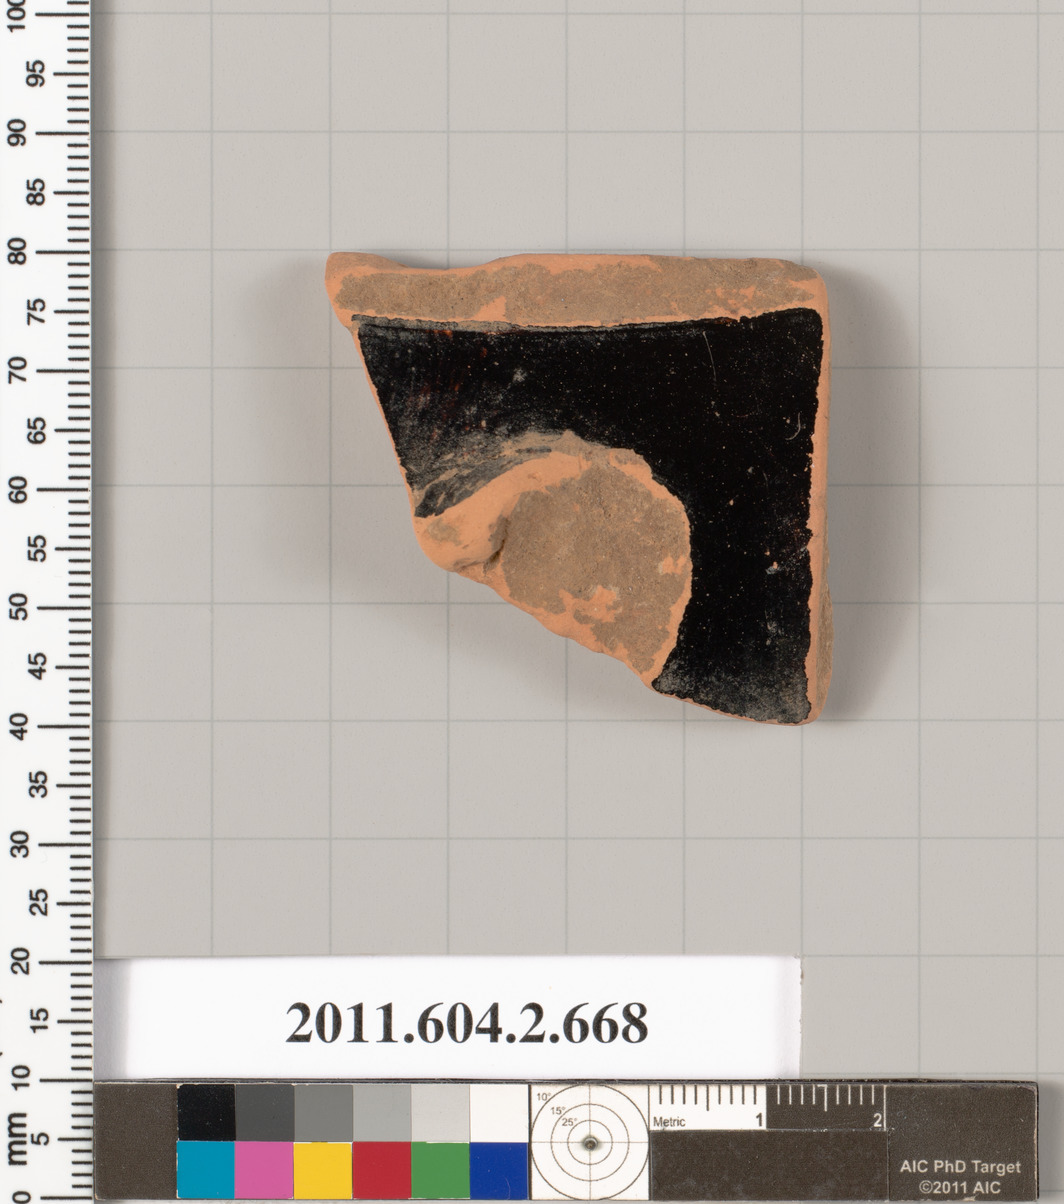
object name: column krater fragment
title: Terracotta fragment of a column-krater (bowl for mixing wine and water)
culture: greek, attic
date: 475-451 BCE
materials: terracotta